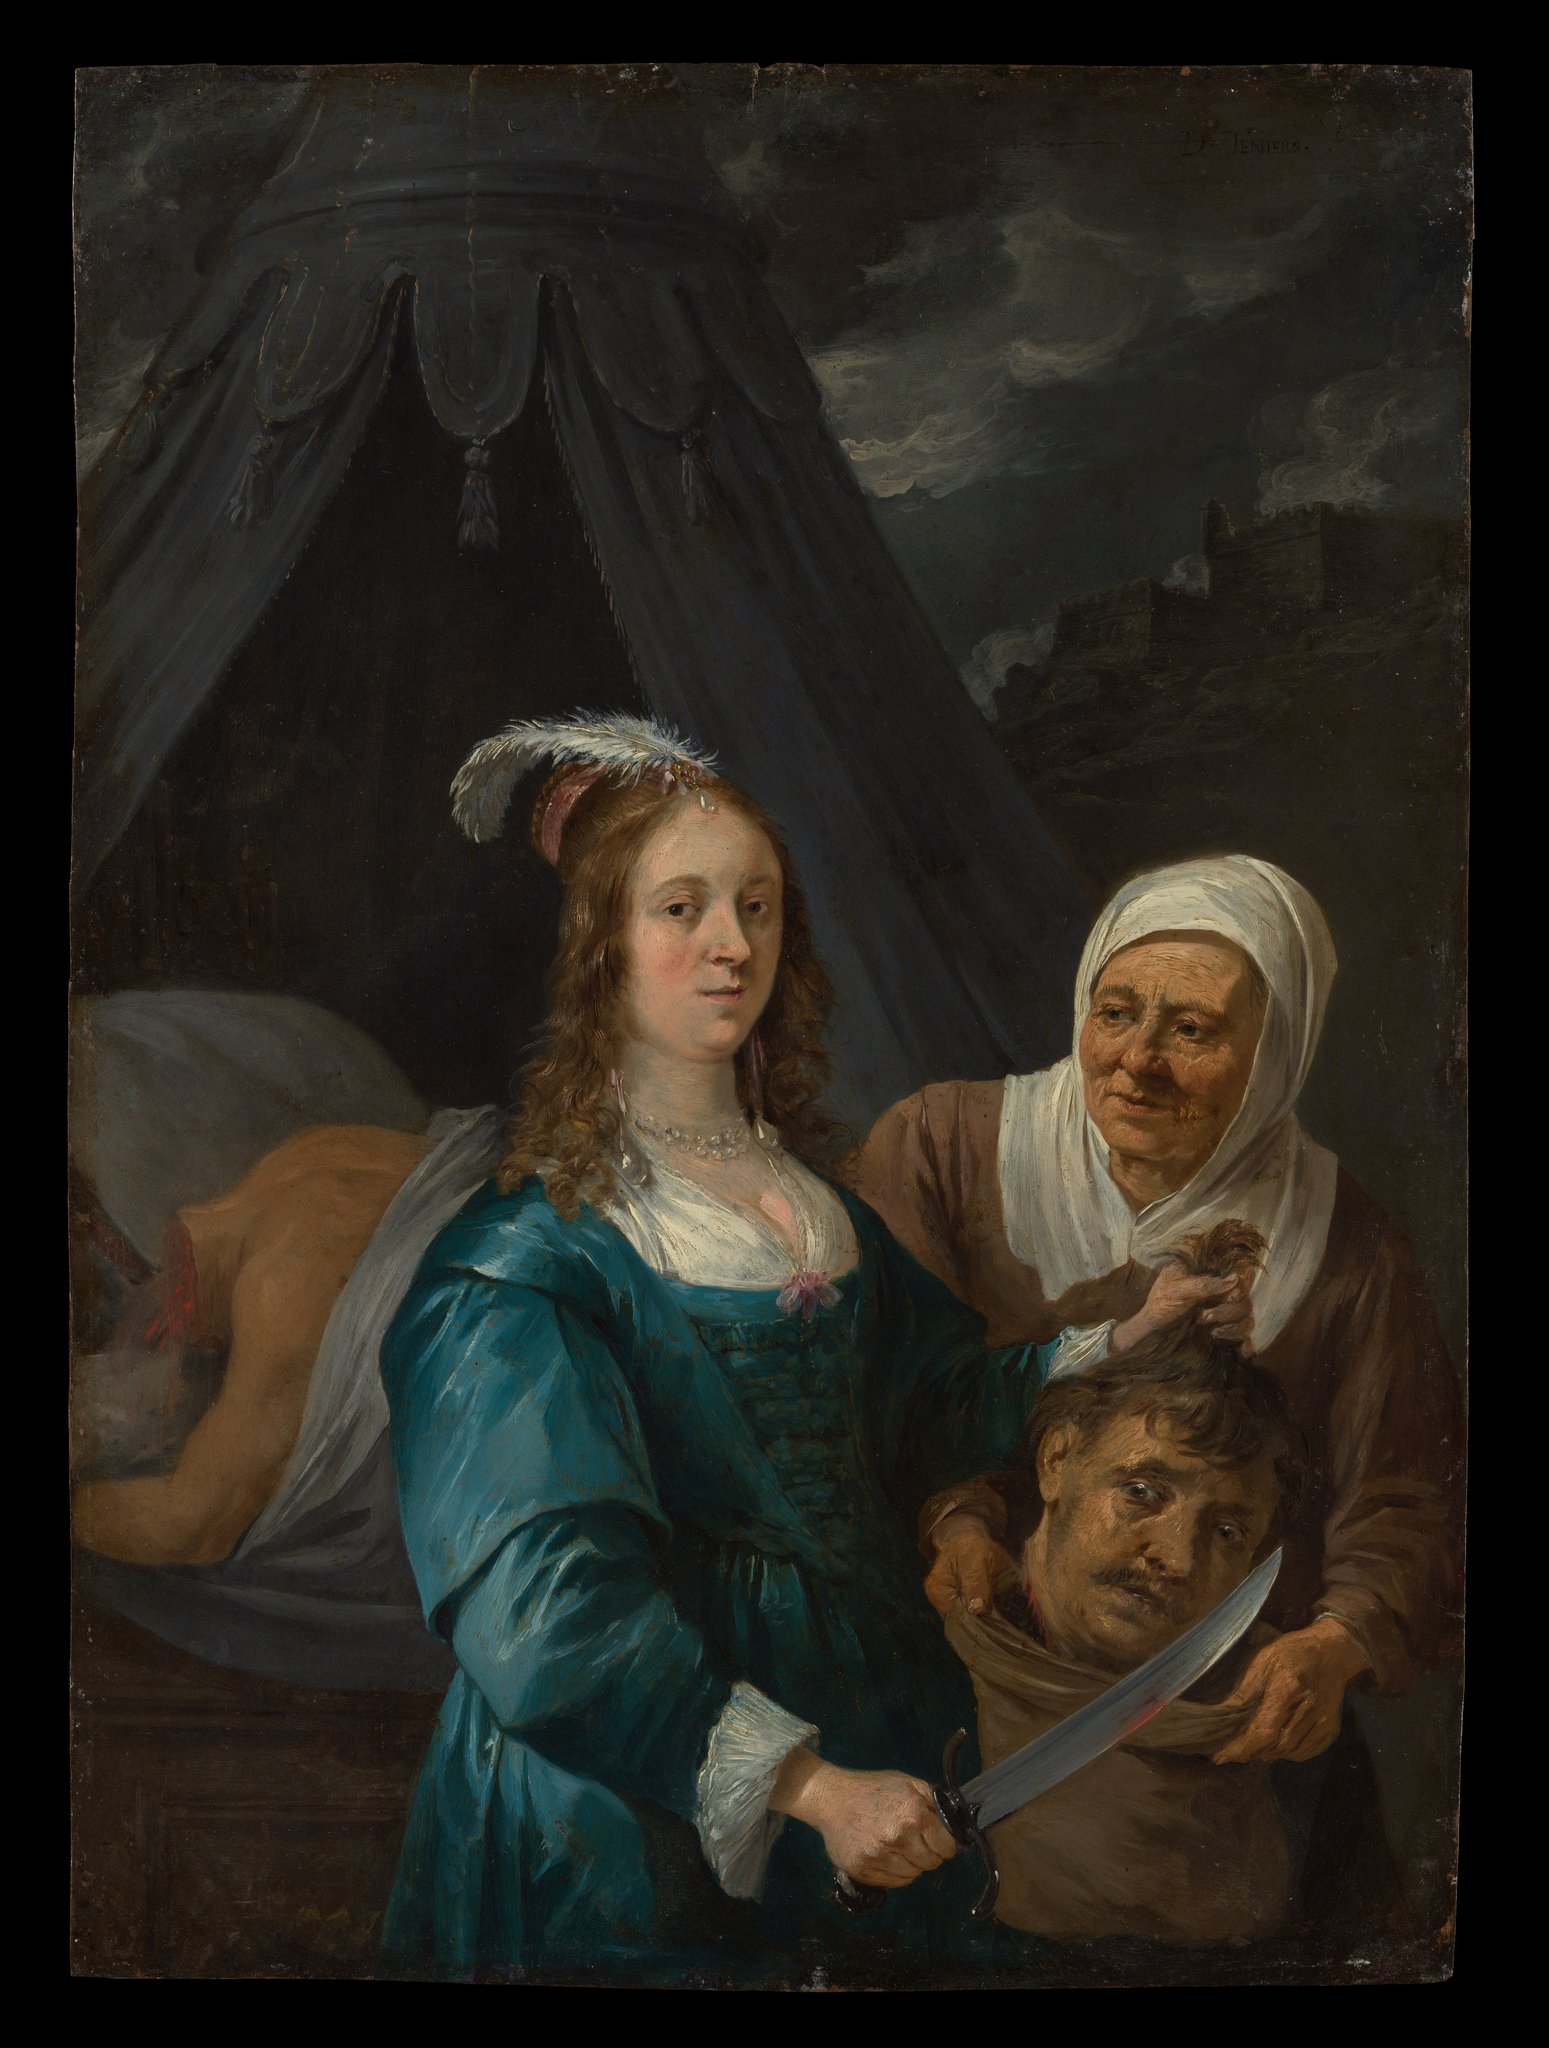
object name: painting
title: Judith with the Head of Holofernes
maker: david teniers the younger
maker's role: artist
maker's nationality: flemish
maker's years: 1610-1690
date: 1650-1659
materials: copper, oil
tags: tents,heads,women,holofernes,judith,servants